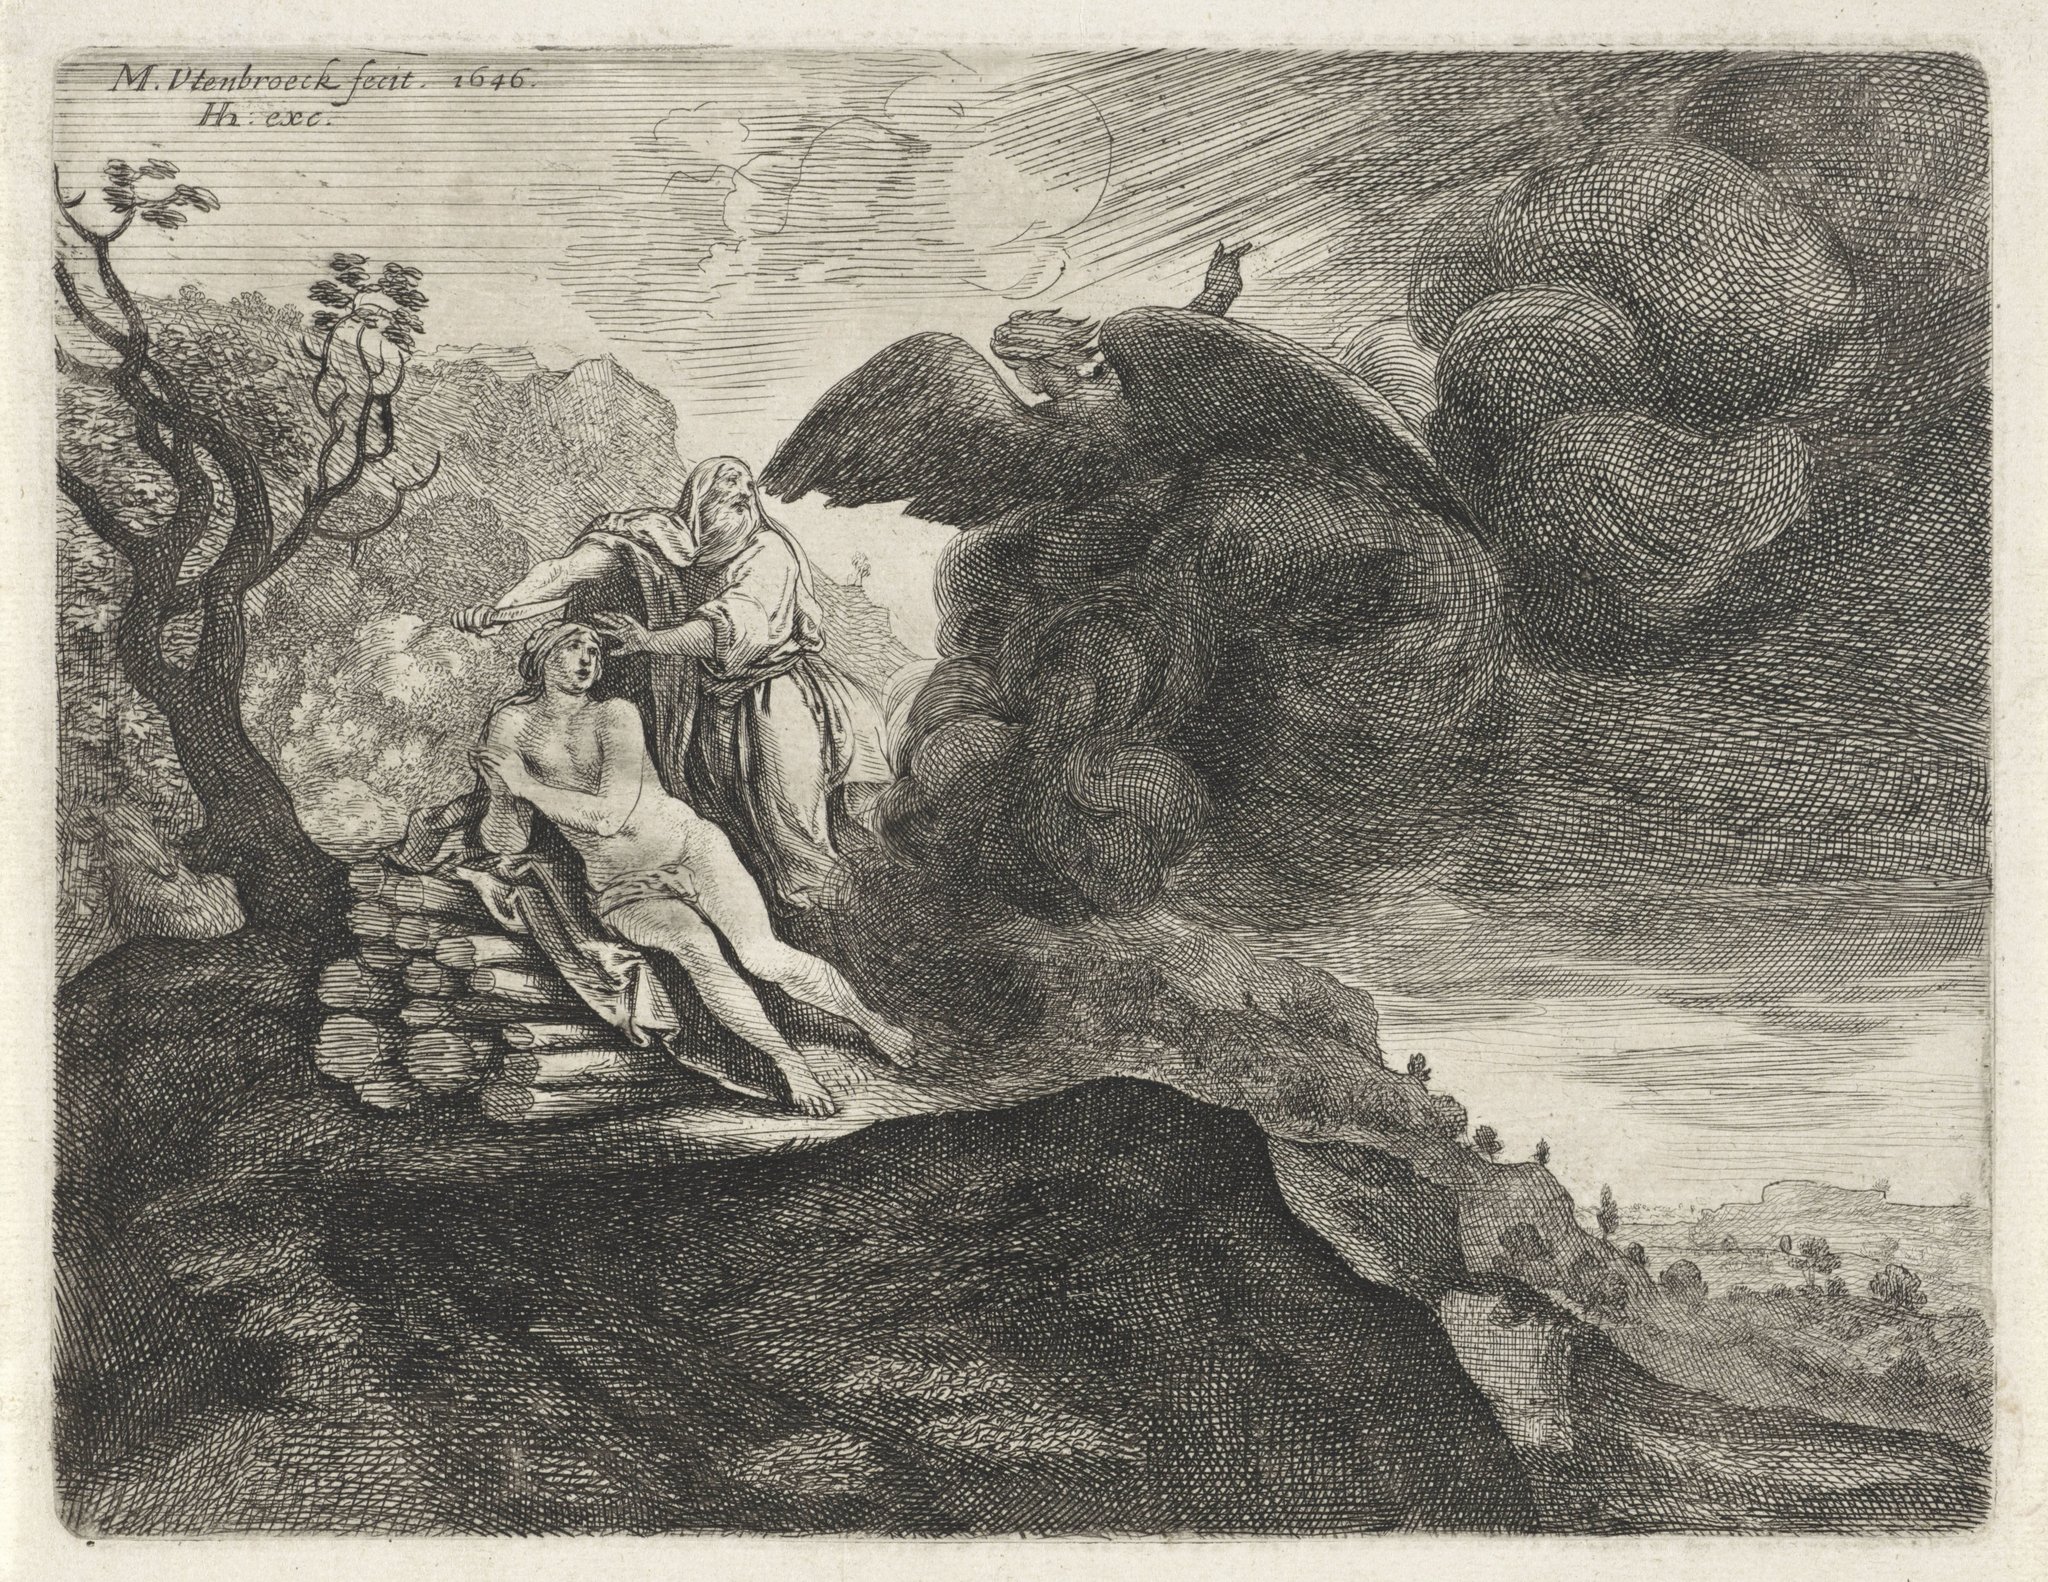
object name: print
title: Het offer van Abraham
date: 1620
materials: paper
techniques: drypoint, engraving, etching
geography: the hague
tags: when abraham has his hand raised to kill isaac, god or the hand of god restrains abraham's hand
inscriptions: collector's mark: Lugt 240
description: Abraham staat met een mes klaar om zijn zoon Isaak te offeren. Boven hem verschijnt in een wolk een engel om hem tegen te houden.